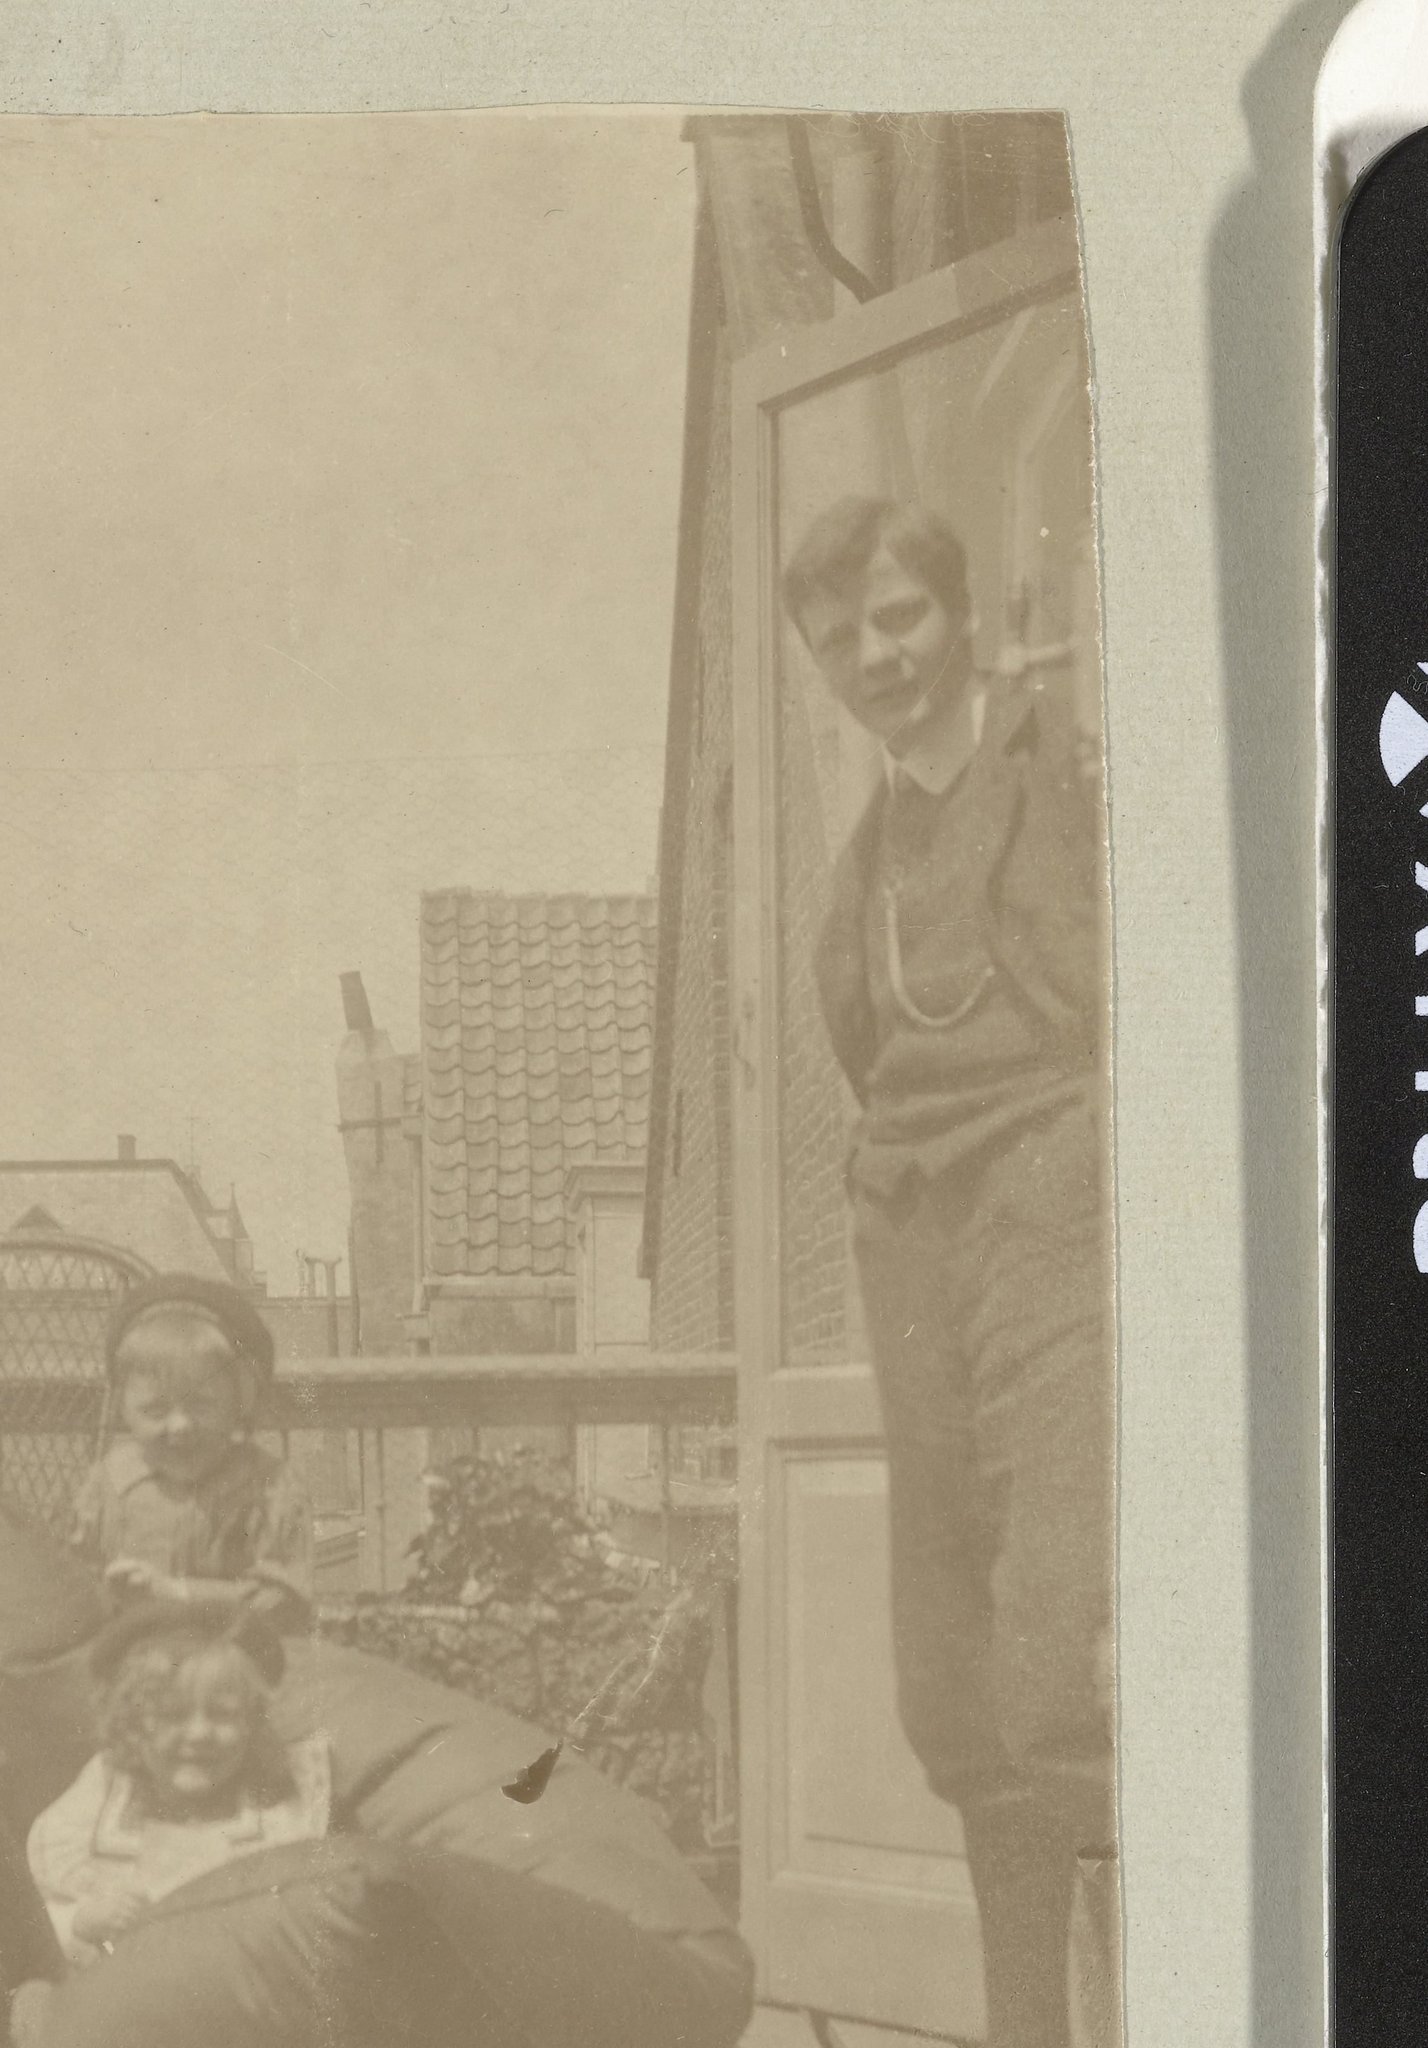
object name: album leaf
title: Groepsportret van vier kinderen van de familie Vermeulen op het balkon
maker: david vermeulen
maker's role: fotograaf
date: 1901-1910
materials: paper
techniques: gelatin silver print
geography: the hague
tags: balcony, child between toddler and youth (of undetermined sex)